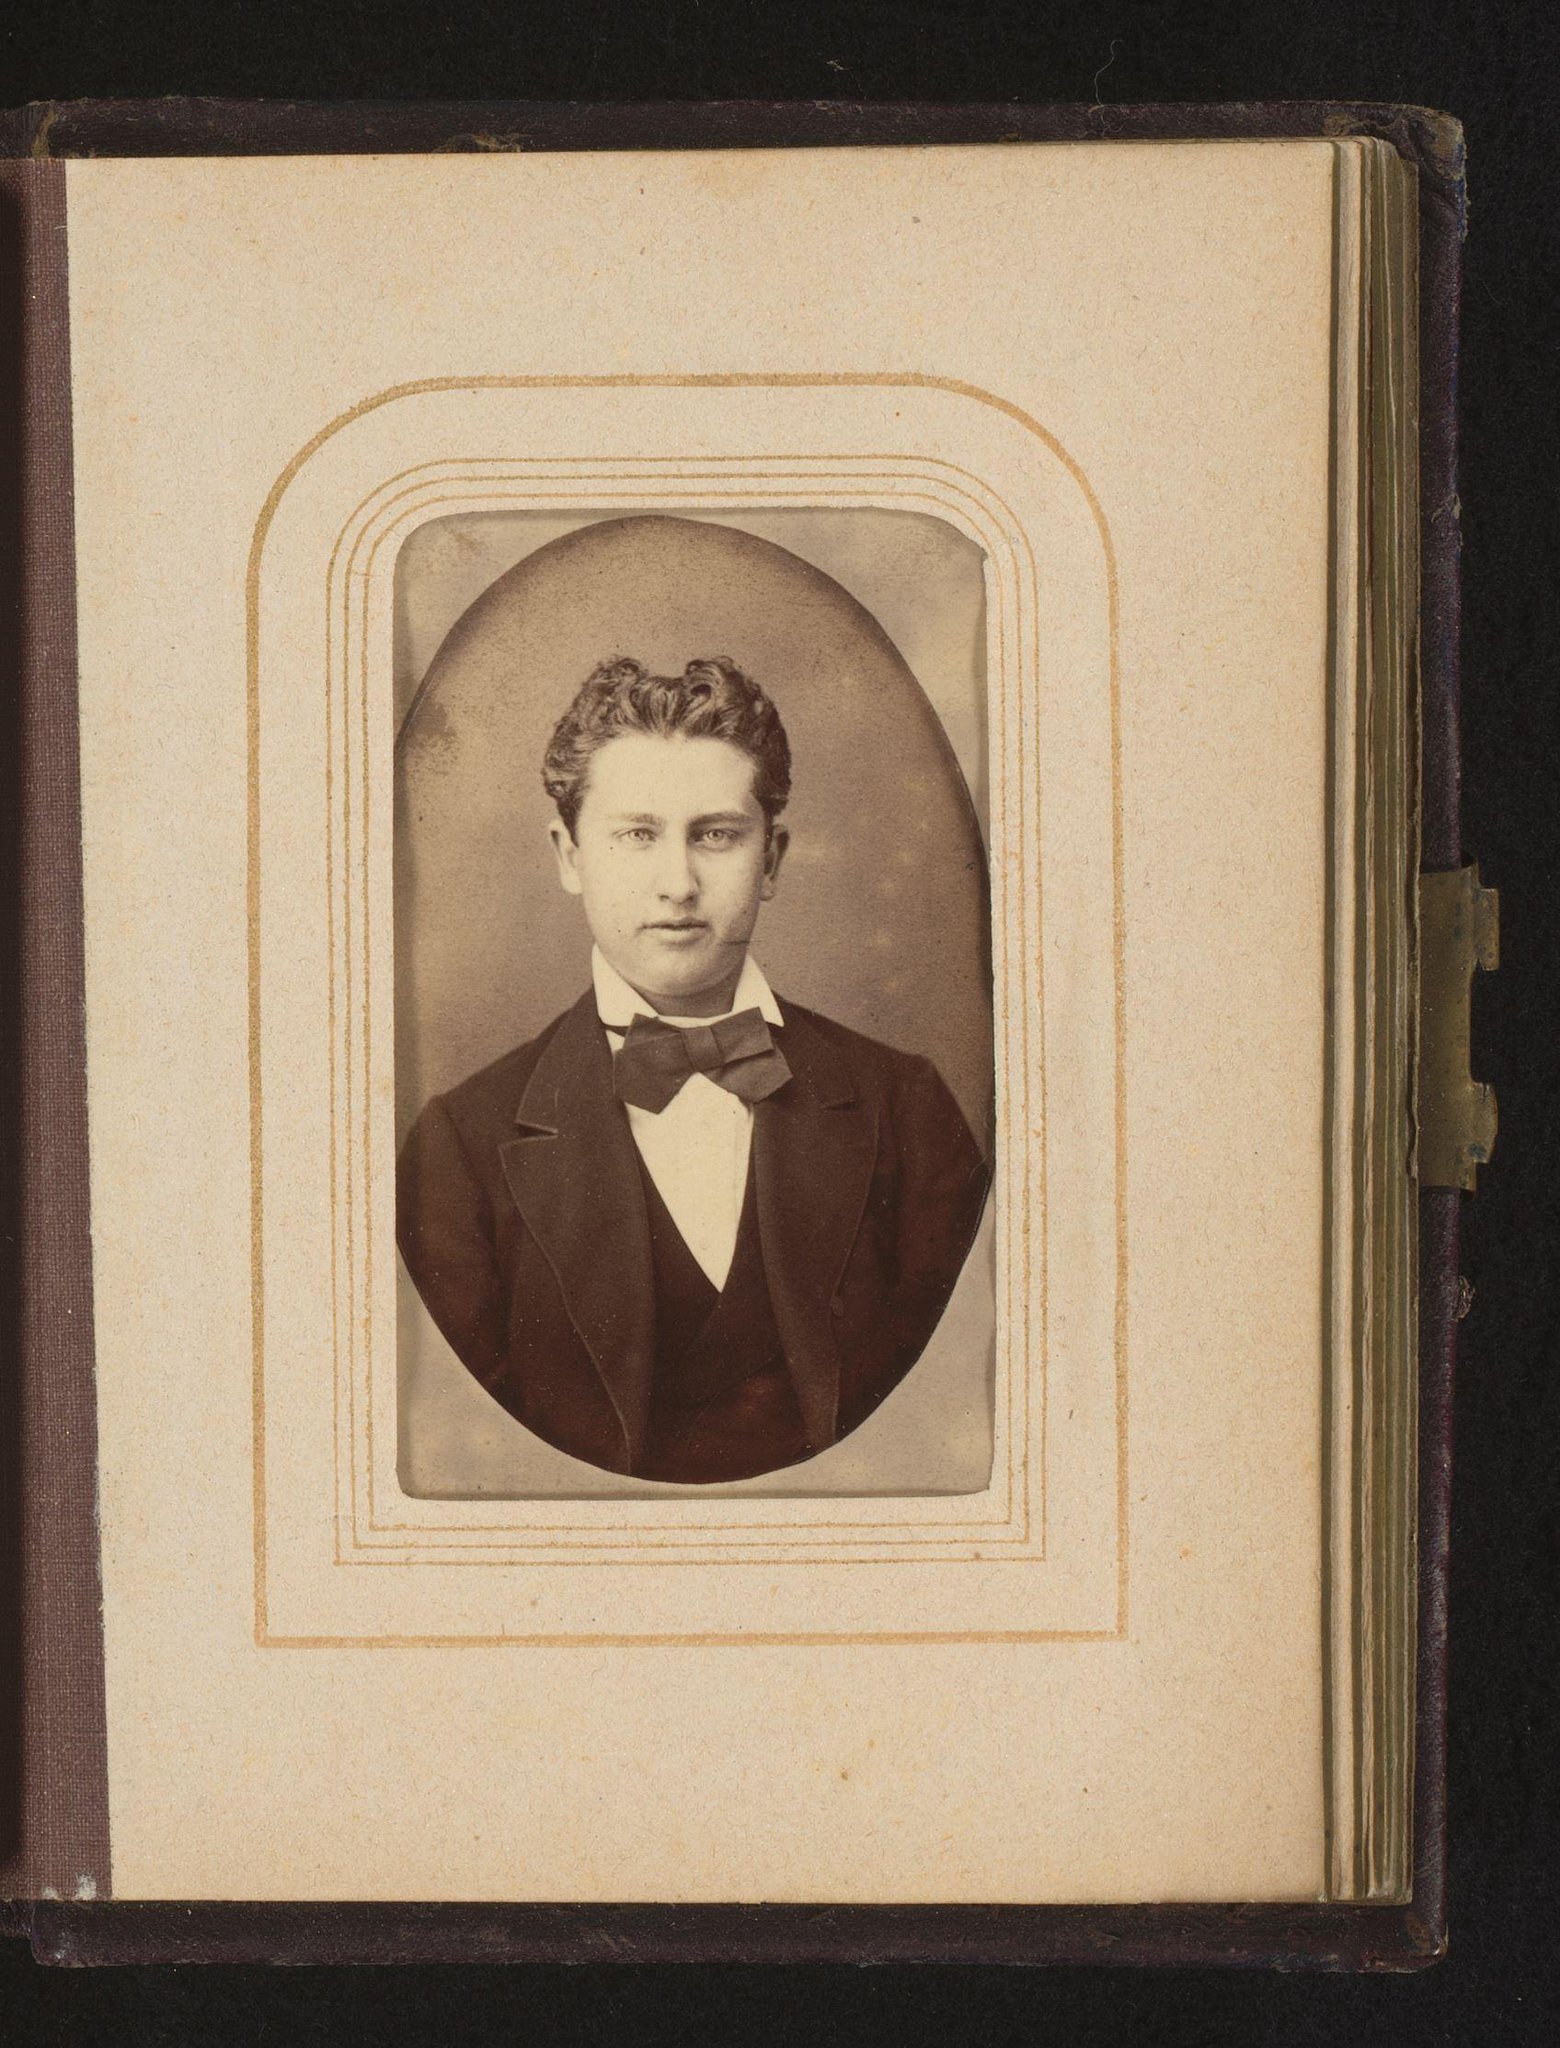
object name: photograph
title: Portret van een jongeman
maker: Anonymous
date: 1860-1900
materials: cardboard, photographic support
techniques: albumen print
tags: youth, adolescent